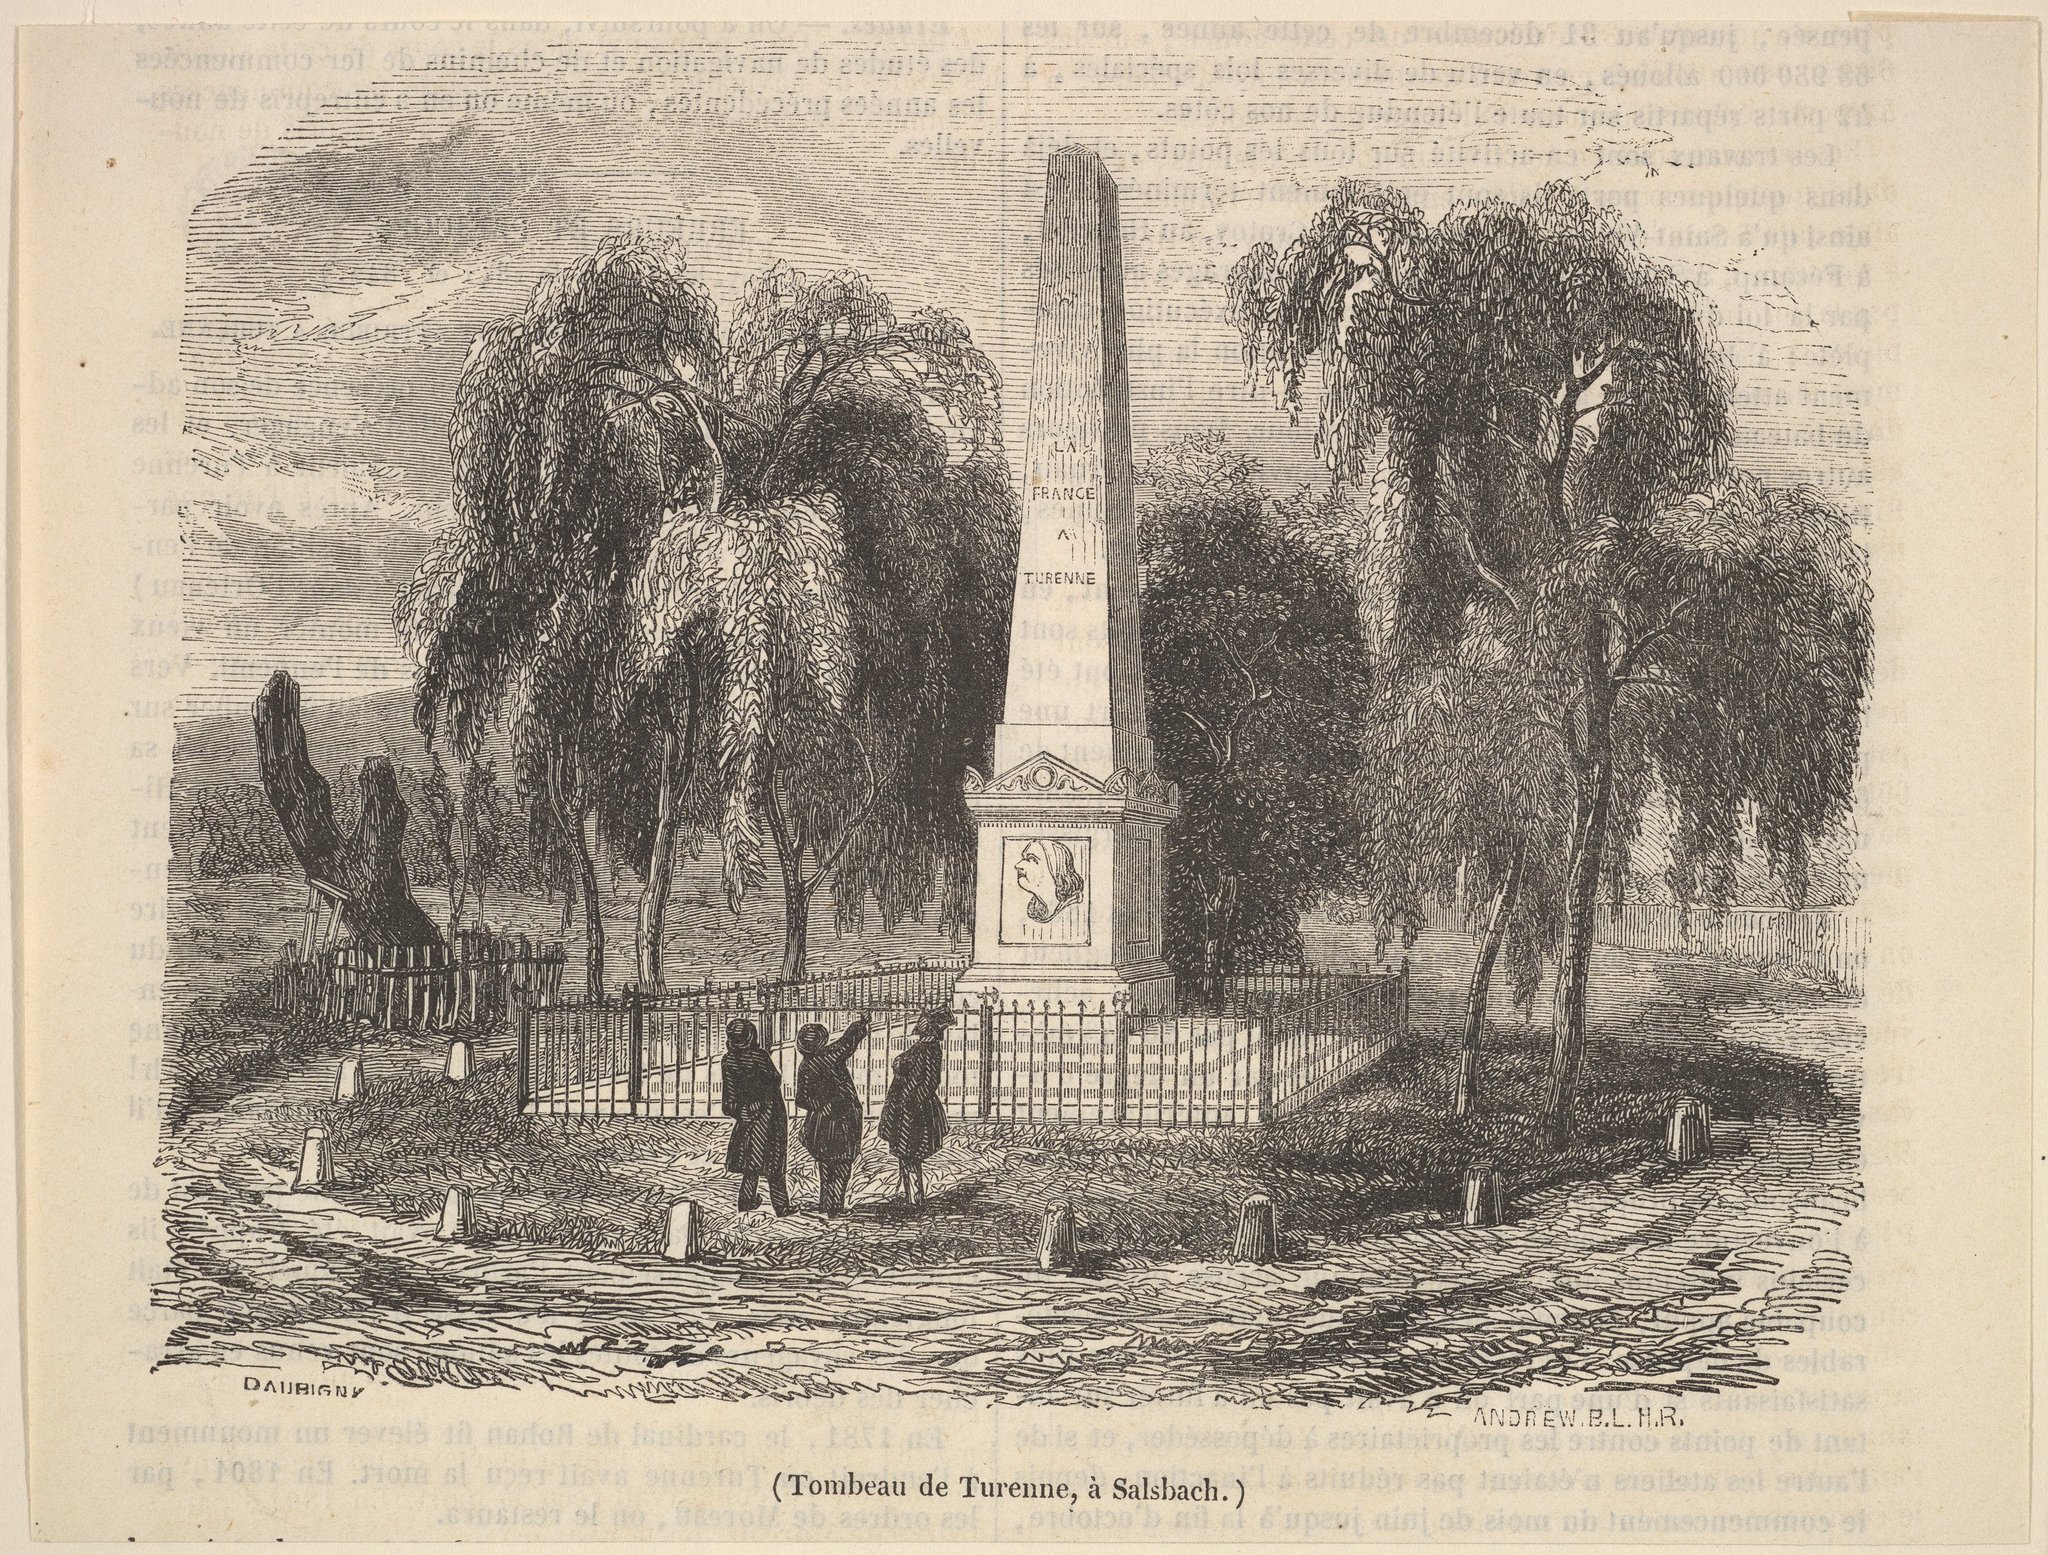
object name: print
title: Tomb of Turenne in Salsbach, from "Le Magasin Pittoresque"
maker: charles-françois daubigny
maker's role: artist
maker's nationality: french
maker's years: 1817-1878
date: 1843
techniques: engraving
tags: monuments,obelisks